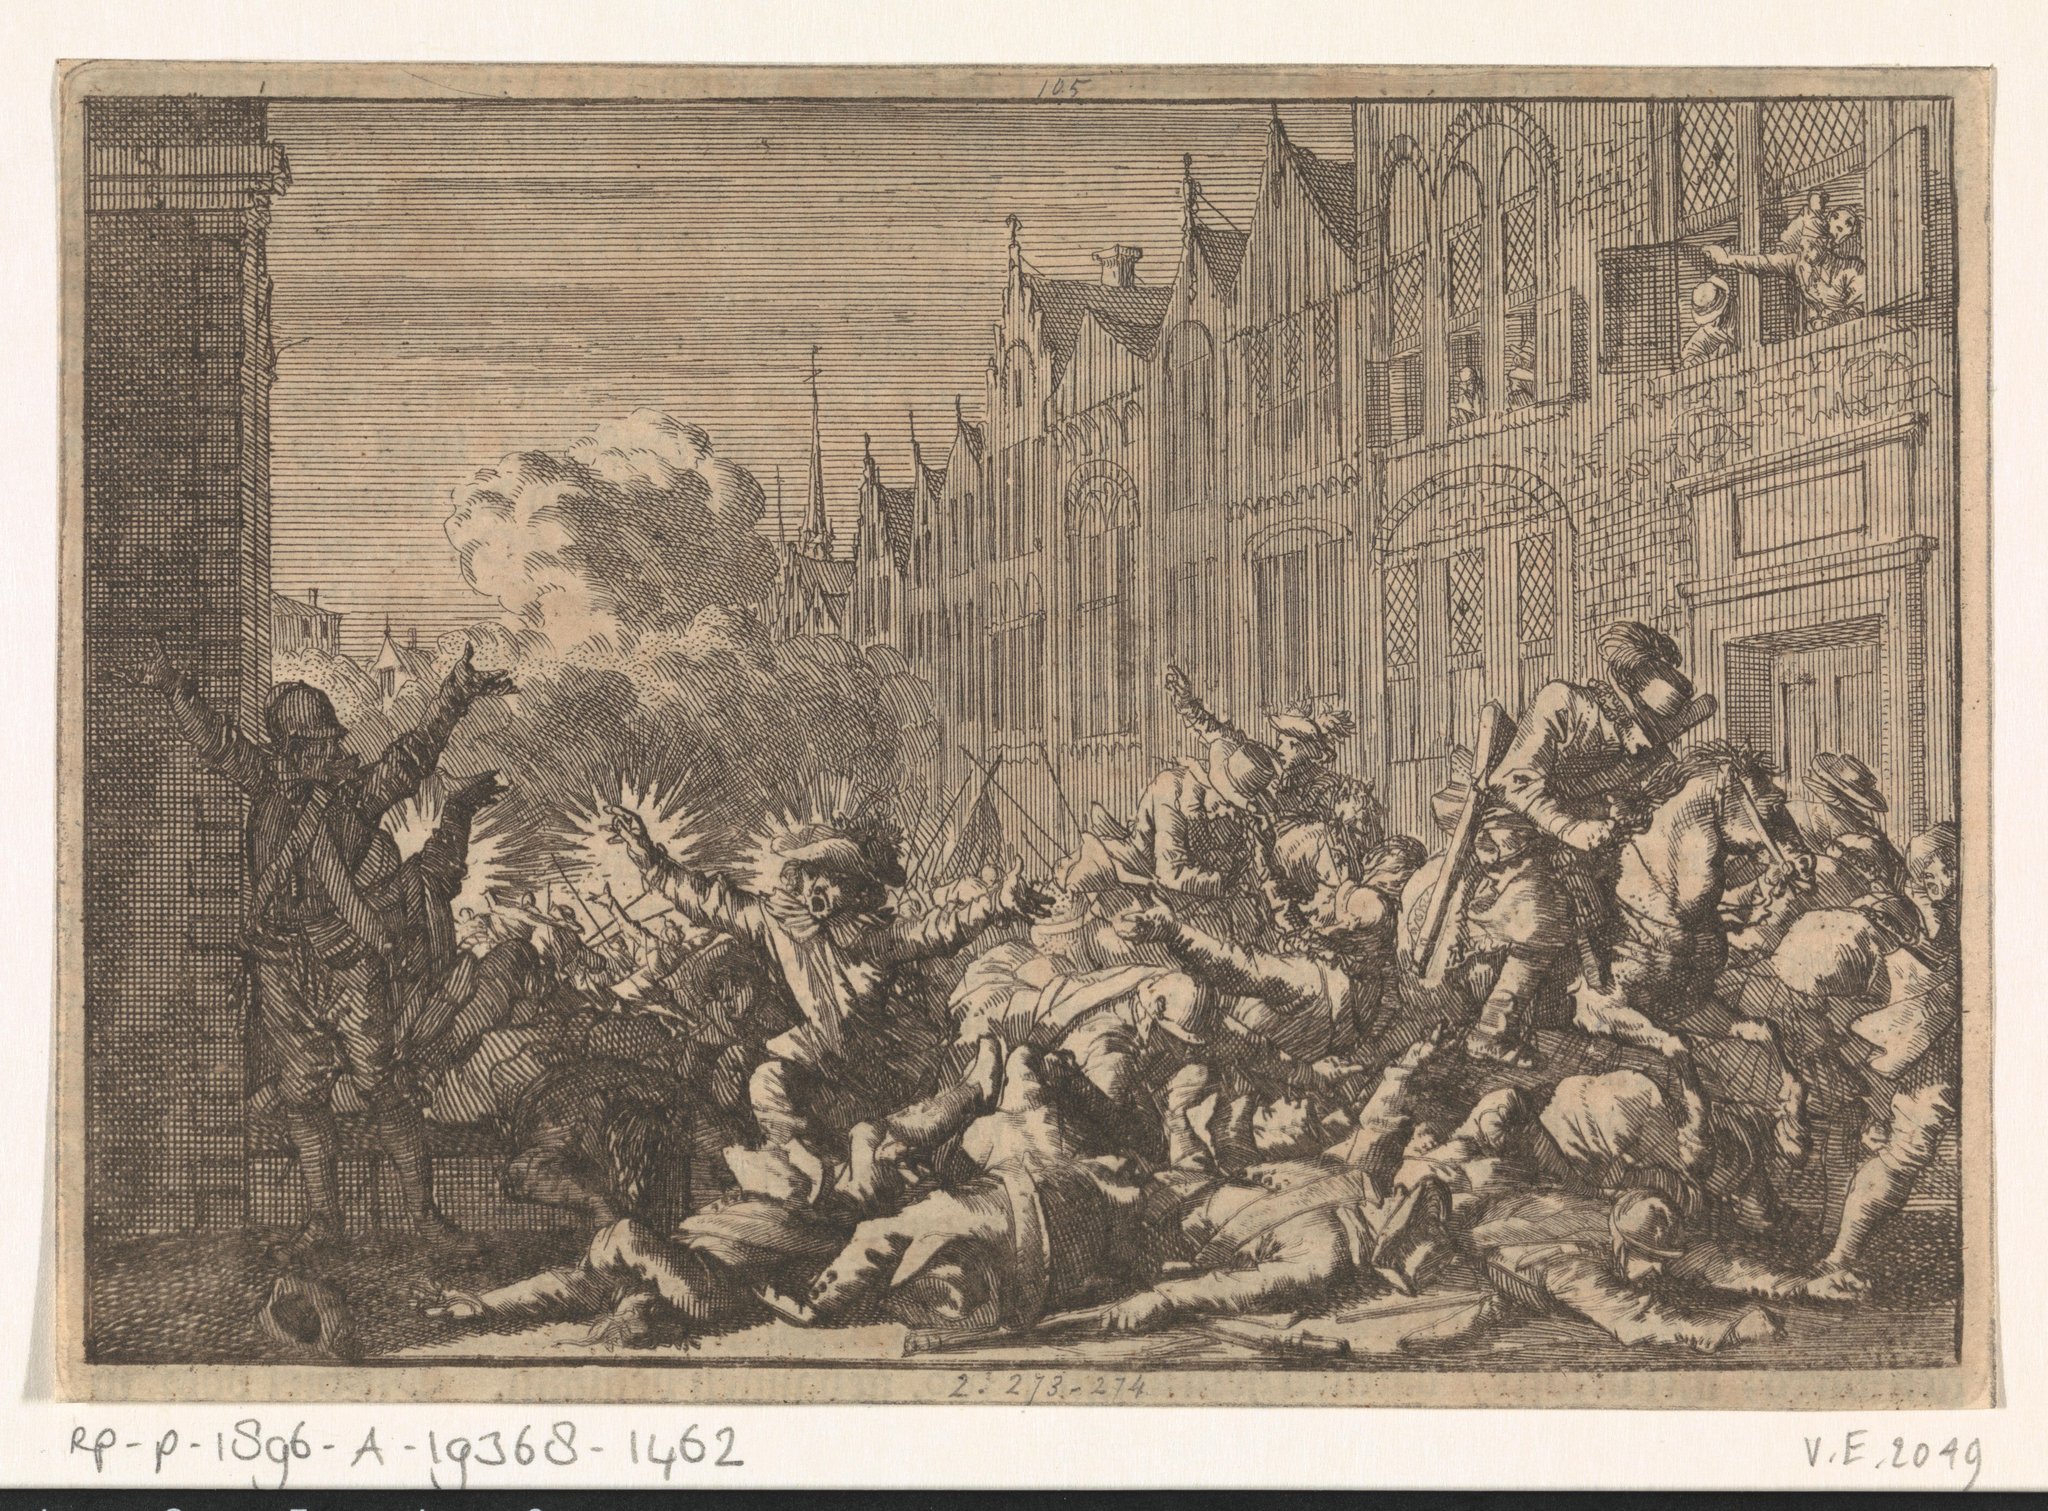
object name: print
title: Angers bezet door aanhangers van Mazarin die in een hinderlaag van tien kanonnen van gouverneur De Rohan lopen, 1652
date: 1698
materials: paper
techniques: etching, letterpress printing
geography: amsterdam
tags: firearms: cannon (+ during the battle), surprise attack (from ambush), siege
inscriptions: collector's mark: Lugt 2228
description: Illustratie uit: Gottfried, Johann Ludwig. Historische kronyck; vervattende een (...) beschrijvingh der aldergedenckwaerdigste geschiedenissen des weerelds, van den aenvangh der scheppingh tot (...) 1576 (2 delen). Leiden: Pieter van der Aa, 1698, dl. II, p. 273.